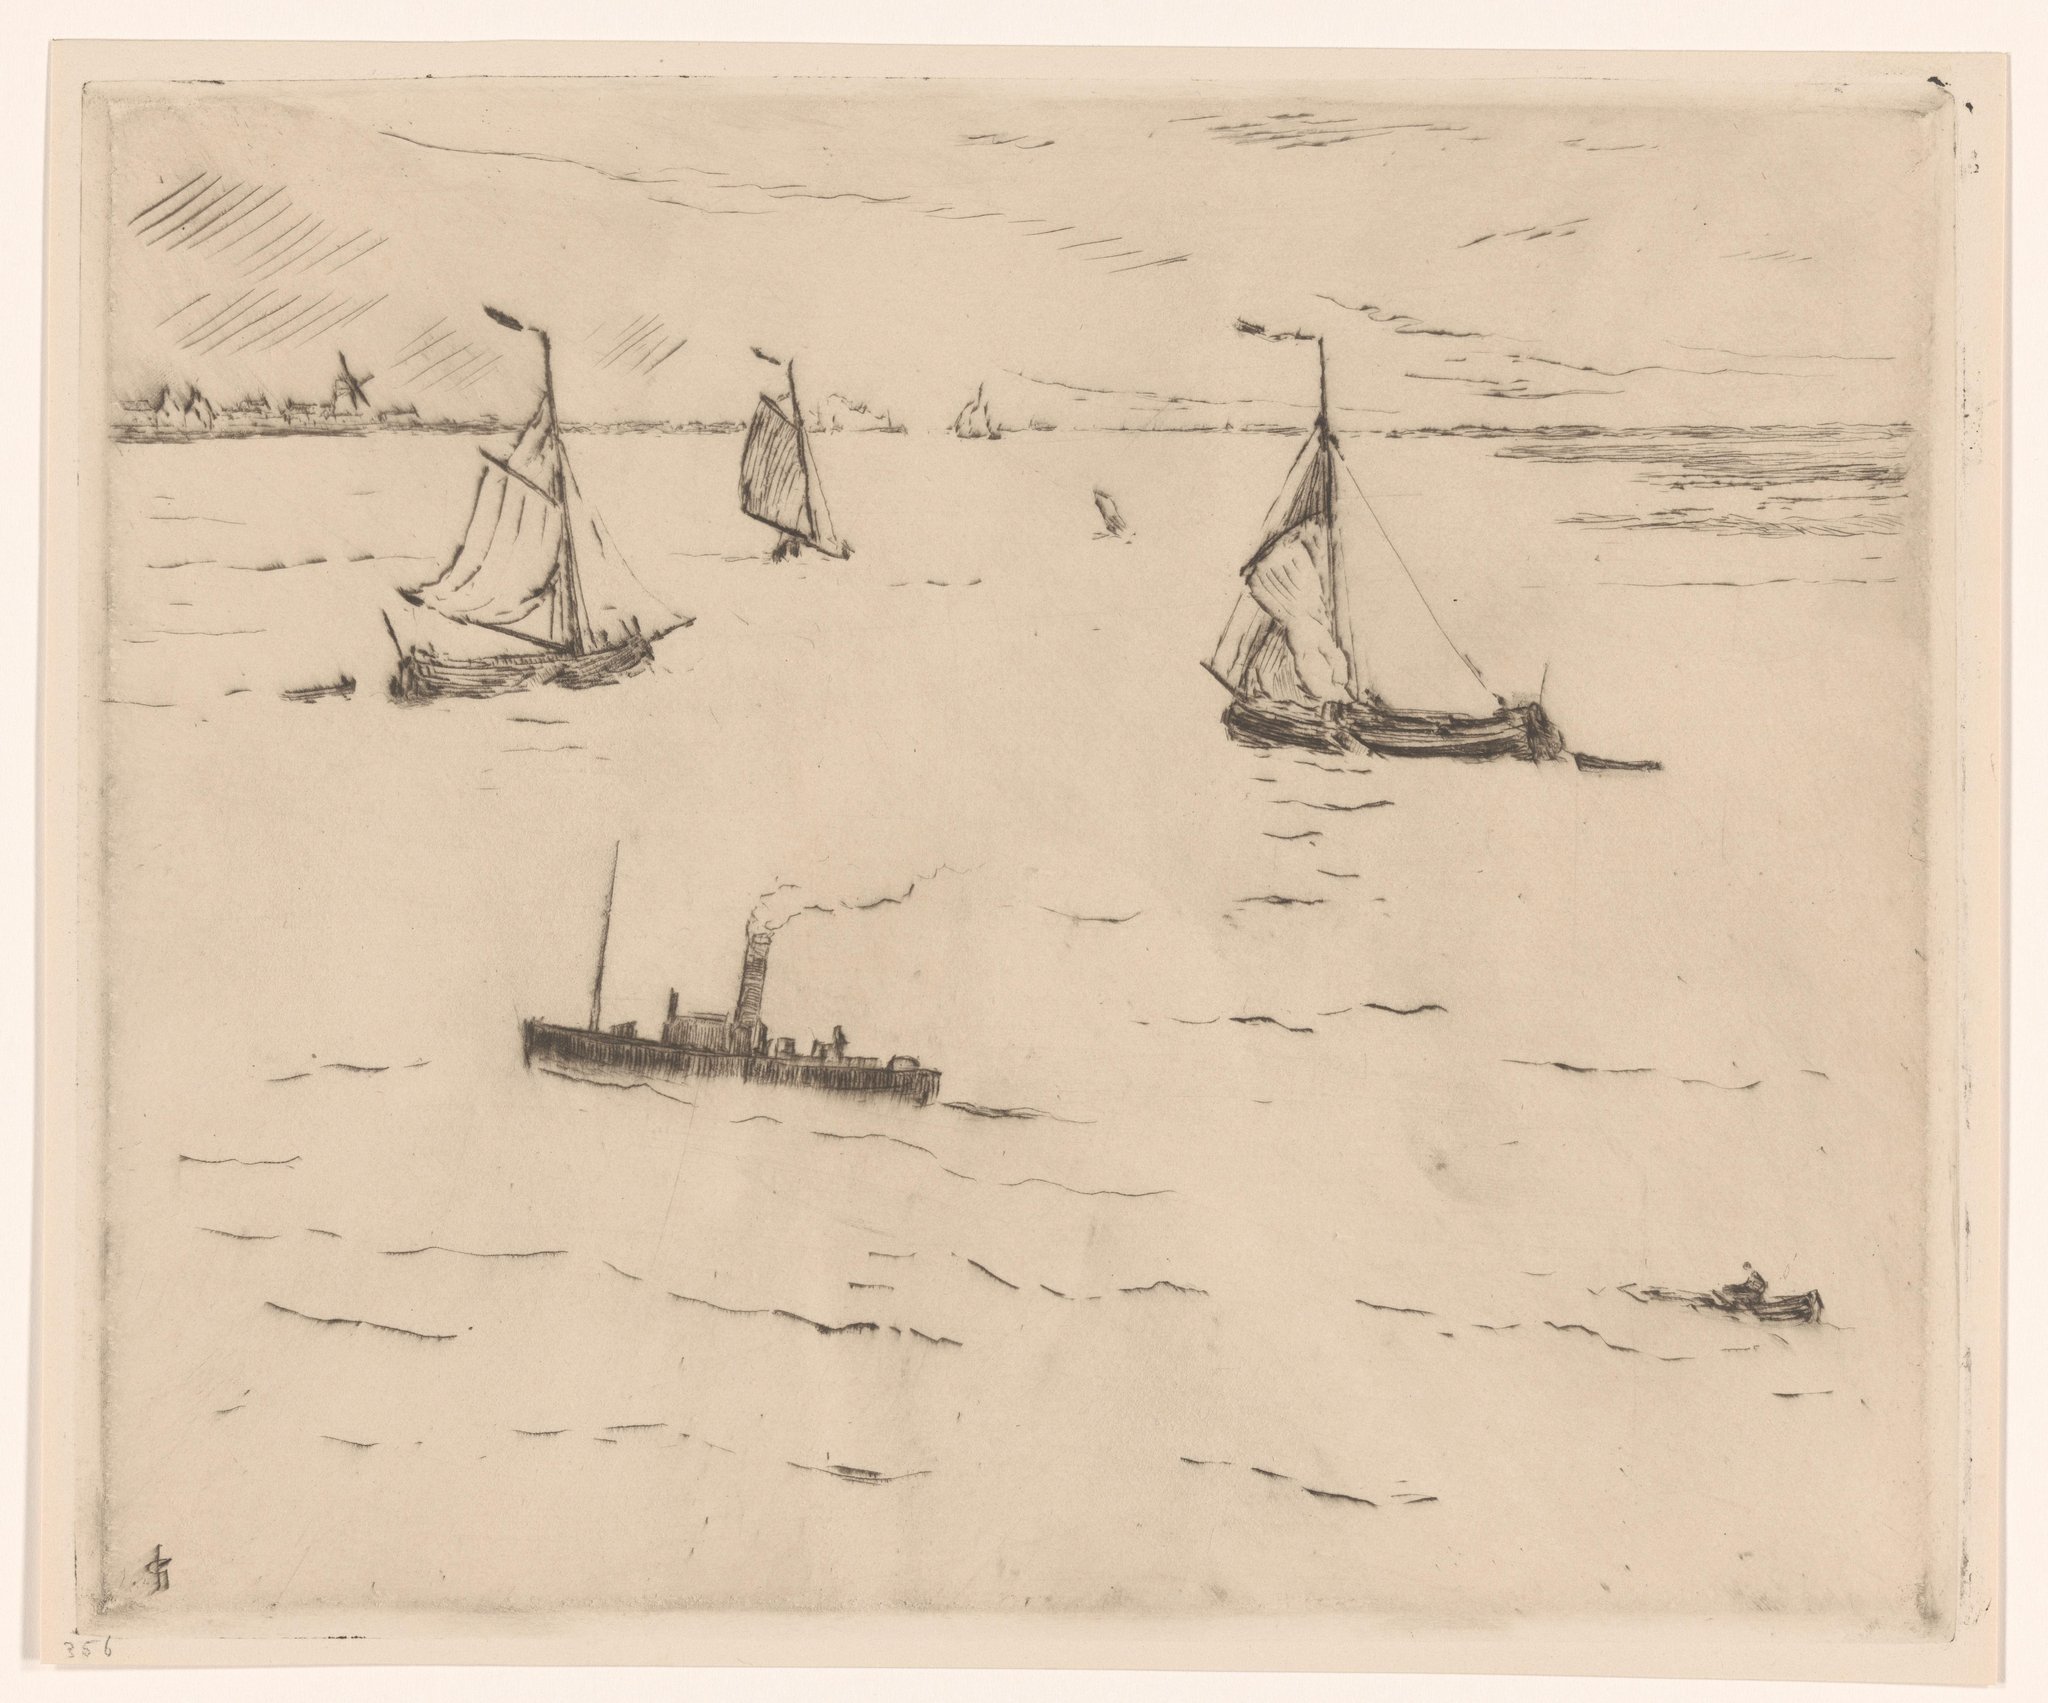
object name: print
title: Stoomboot en zeilschepen op de Maas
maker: carel nicolaas storm van s-gravesande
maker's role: draughtsman, print maker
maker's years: 1841-1924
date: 1851-1902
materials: paper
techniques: drypoint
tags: river (+ landscape with figures, staffage), traffic on the water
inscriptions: collector's mark: Lugt 2228, number: ‘356’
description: Mogelijk vermeld in: Storm van 's-Gravesande, Charles. Catalogue des eaux-fortes et lithographies. New York: s.n., 1903, of in een onbekende latere uitgave van het manuscript. Vermoedelijk vermeld als catalogusnummer 356.